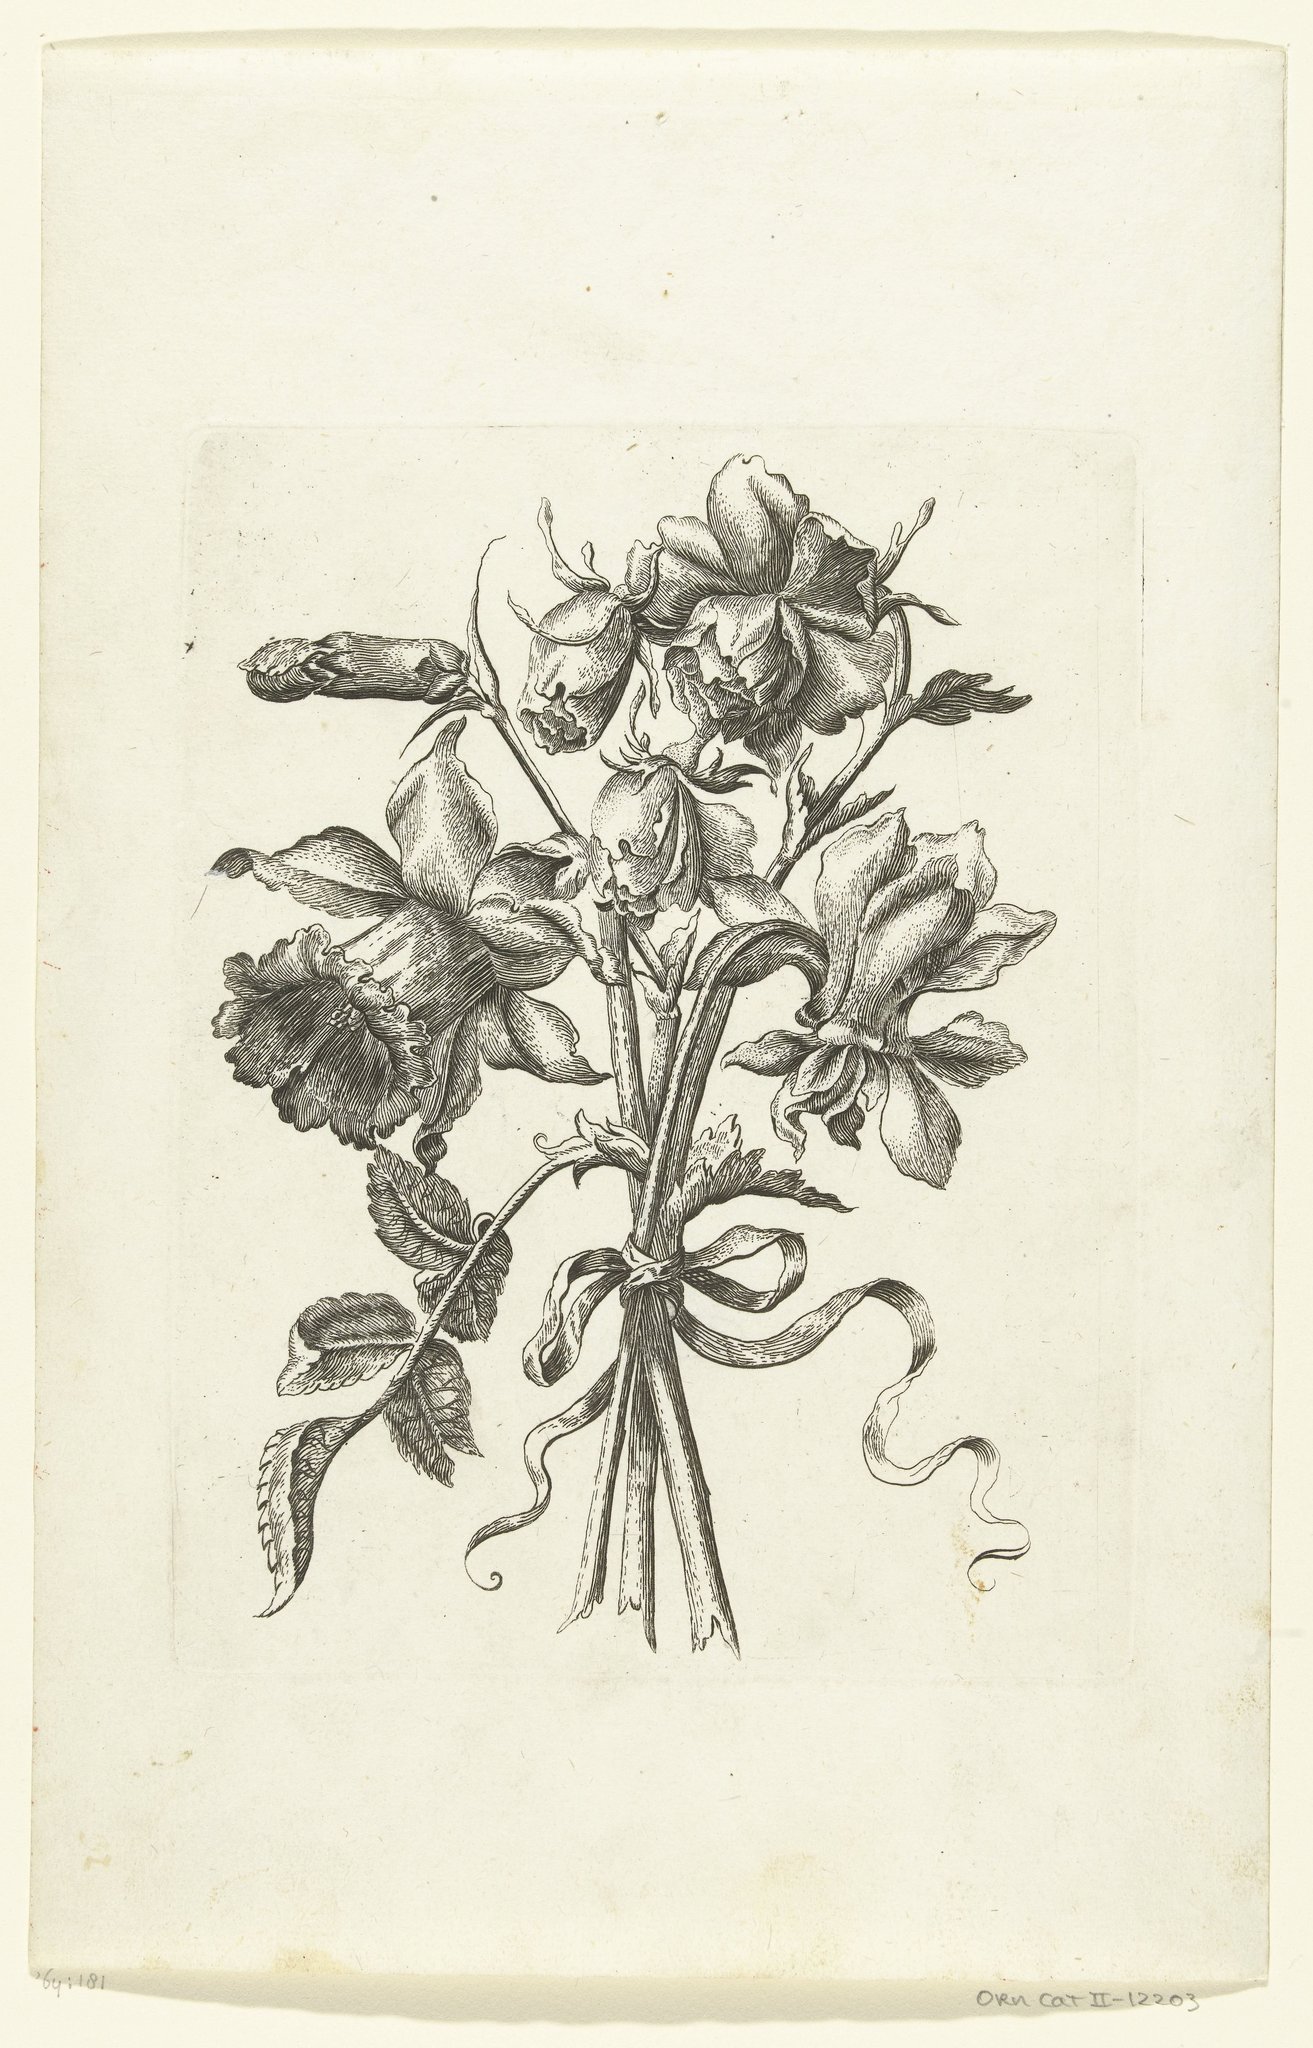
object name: print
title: Novae Florum Icones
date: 1667-1701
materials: paper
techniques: etching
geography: netherlands